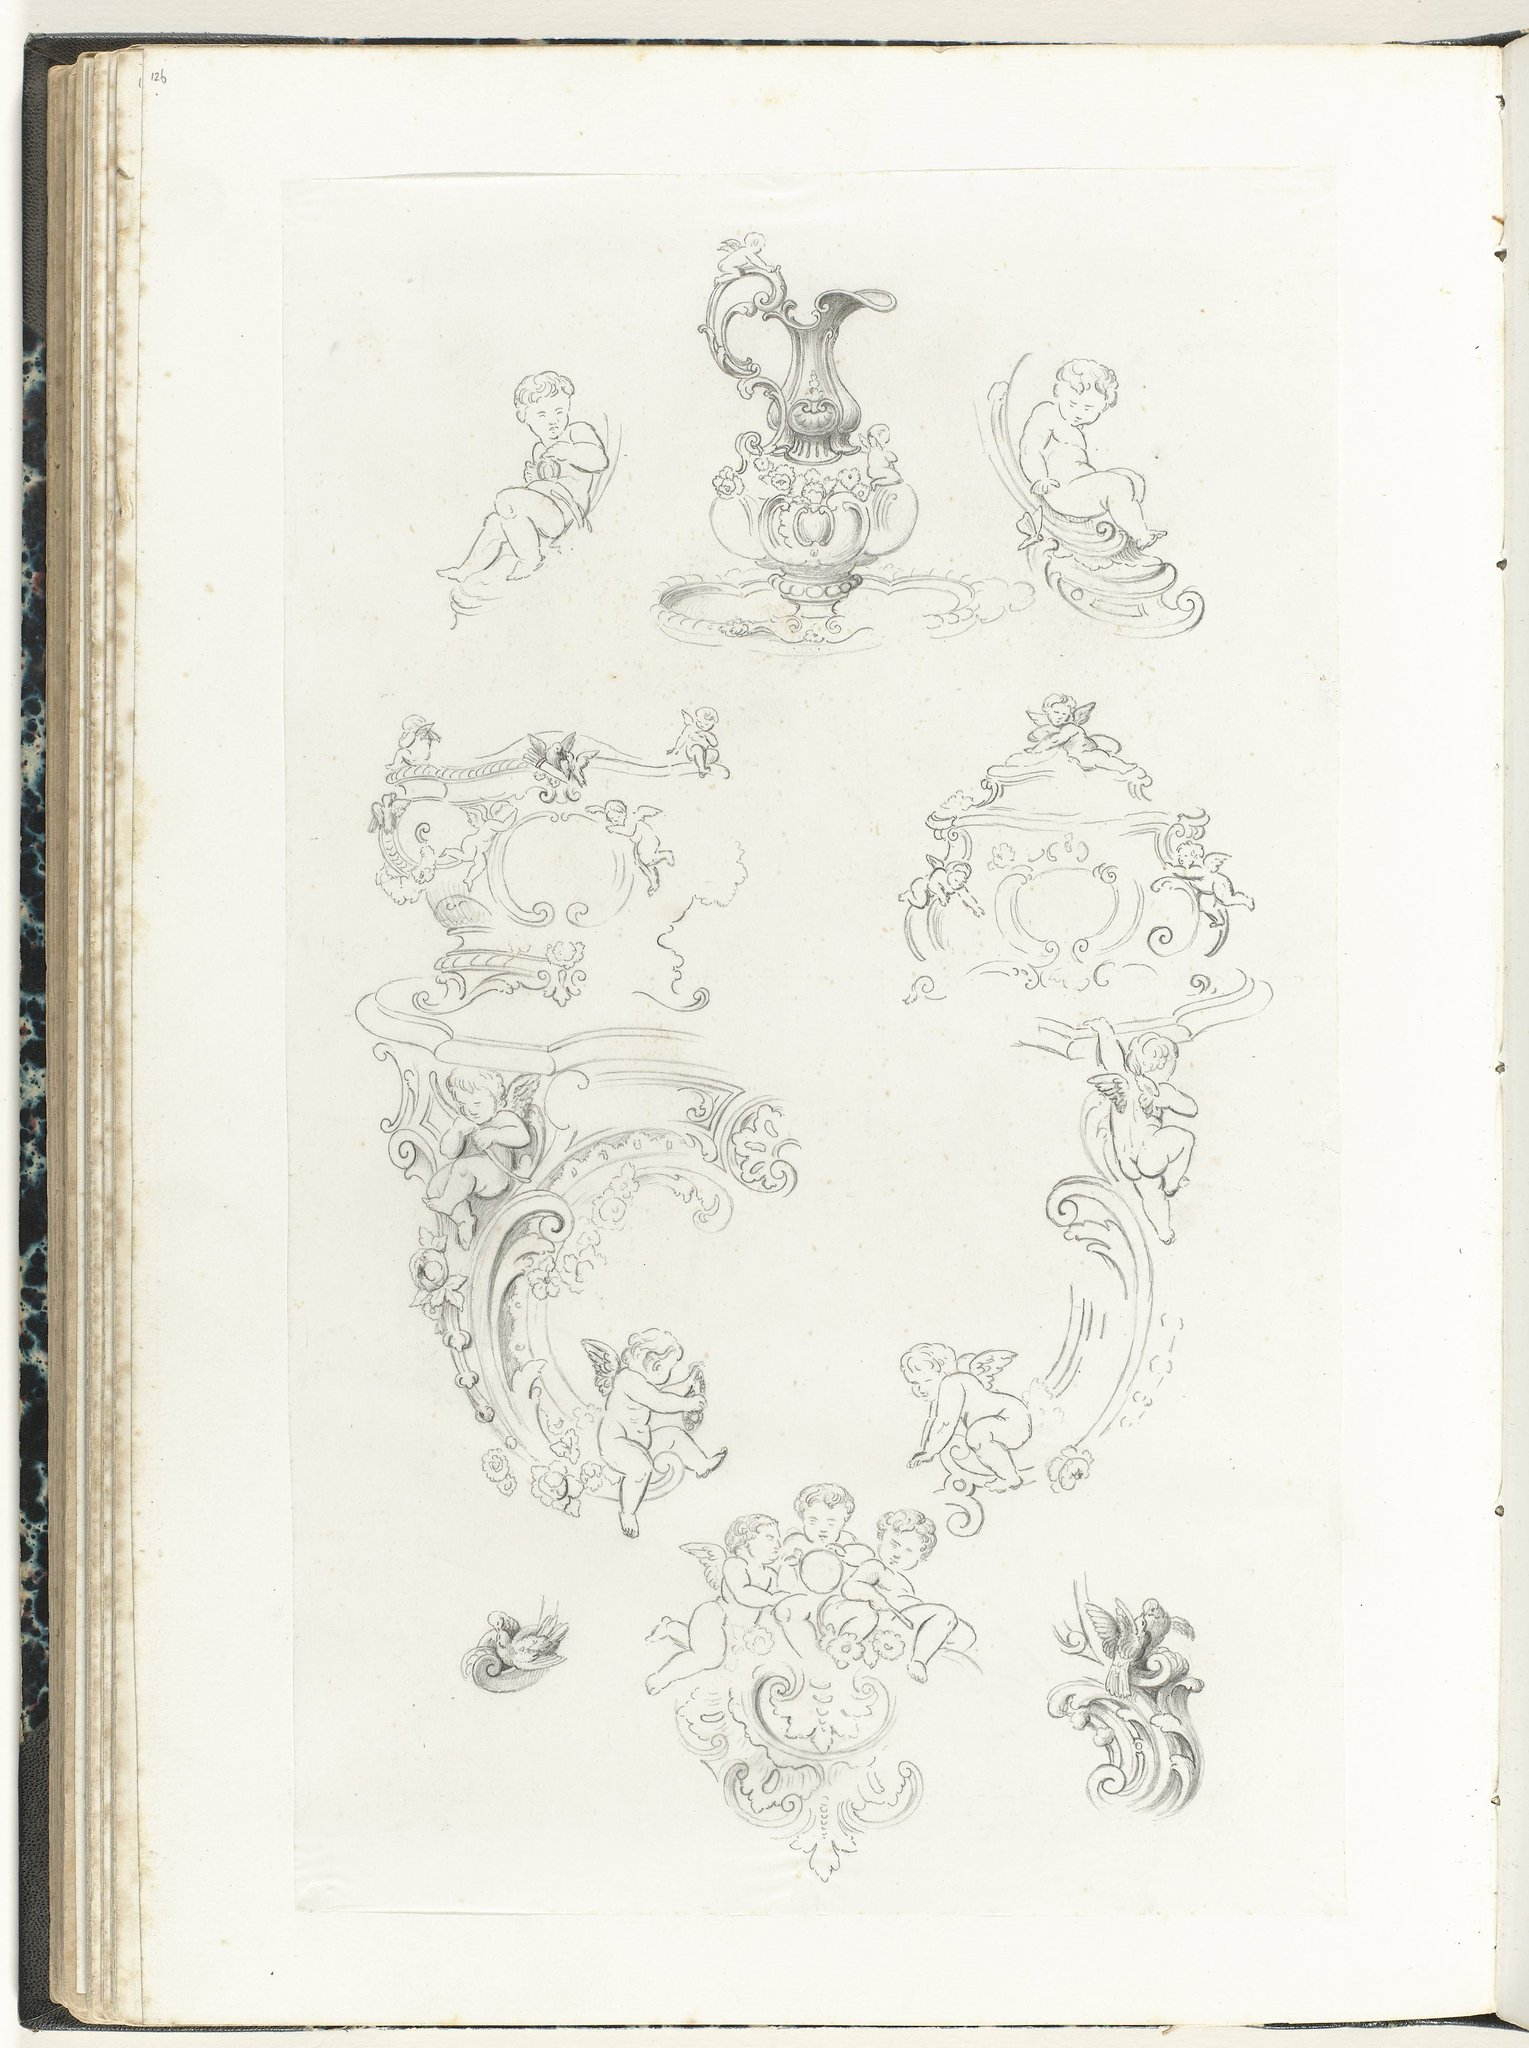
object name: drawing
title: Vaatwerk en details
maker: Anonymous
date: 1866-1900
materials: pencil, paper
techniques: drawing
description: Midden boven staat een schenkkan tussen twee ornamenten voor vaatwerk met putti.